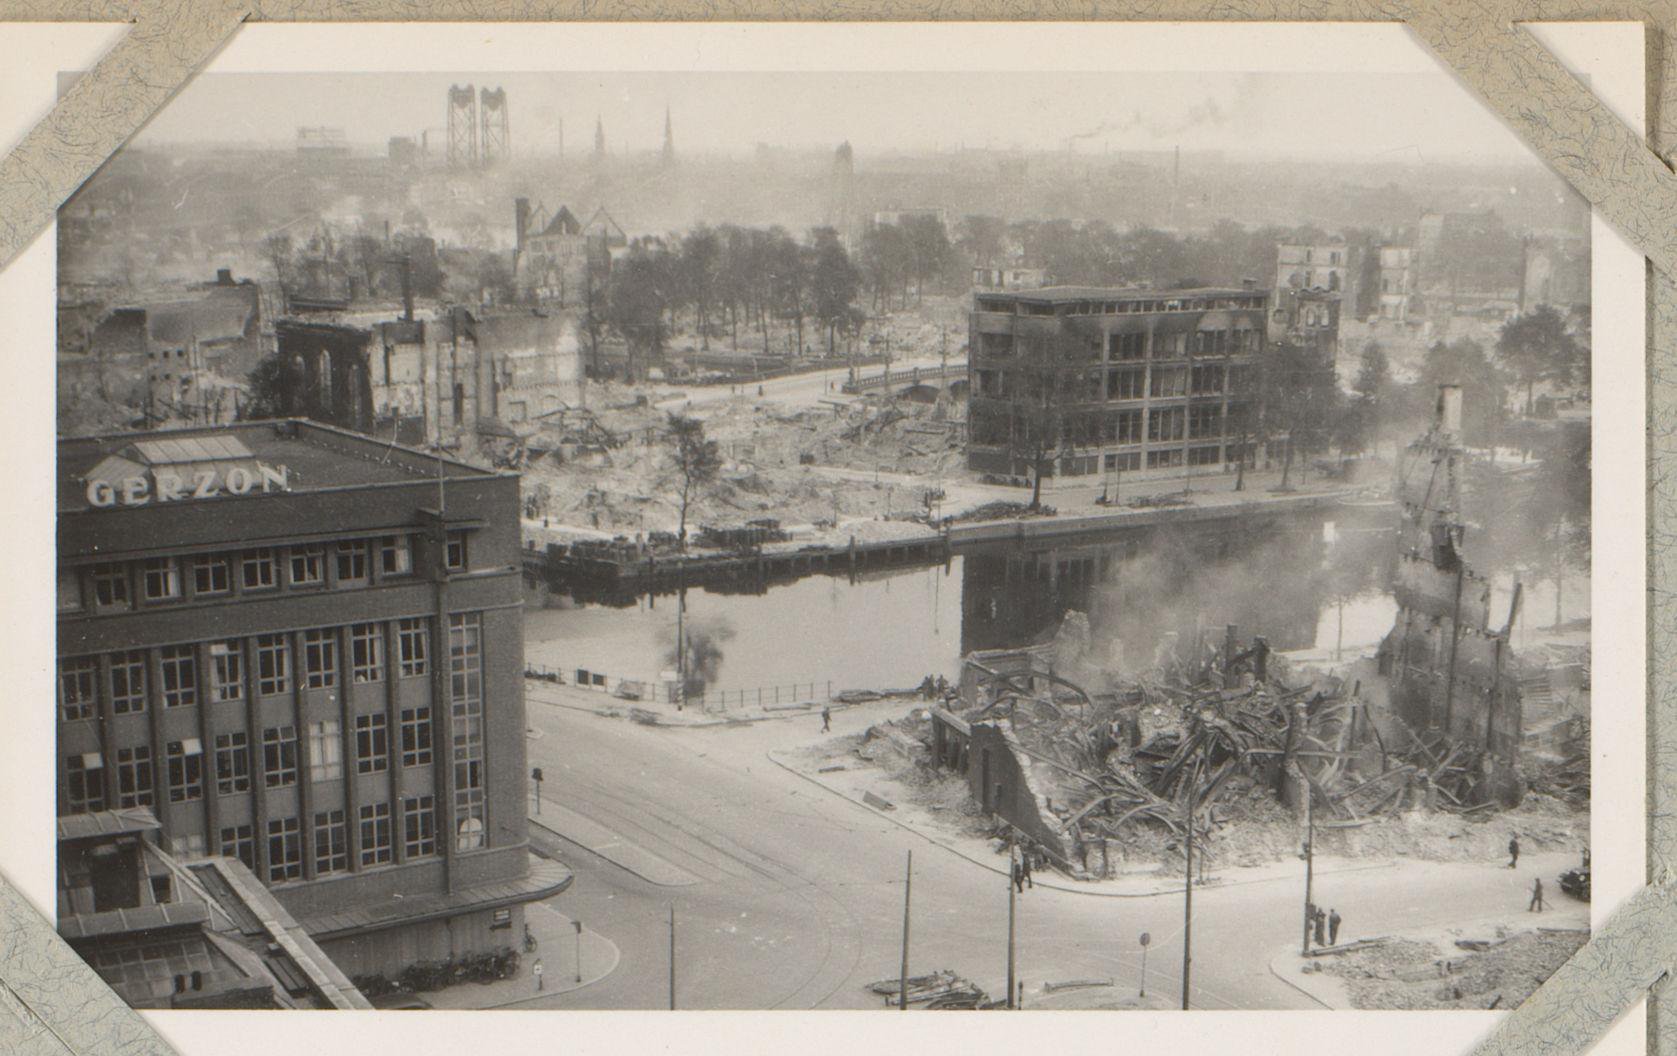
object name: ansichtkaart, prentbriefkaart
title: Ruïnes bij de Leuvehaven te Rotterdam, gezien vanaf de Karrensteeg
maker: j. nolte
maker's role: fotograaf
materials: photographic support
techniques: gelatin silver print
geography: rotterdam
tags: city-view in general; 'veduta', devastated, ruined place or city (~ warfare), rotterdam, rotterdam blitz